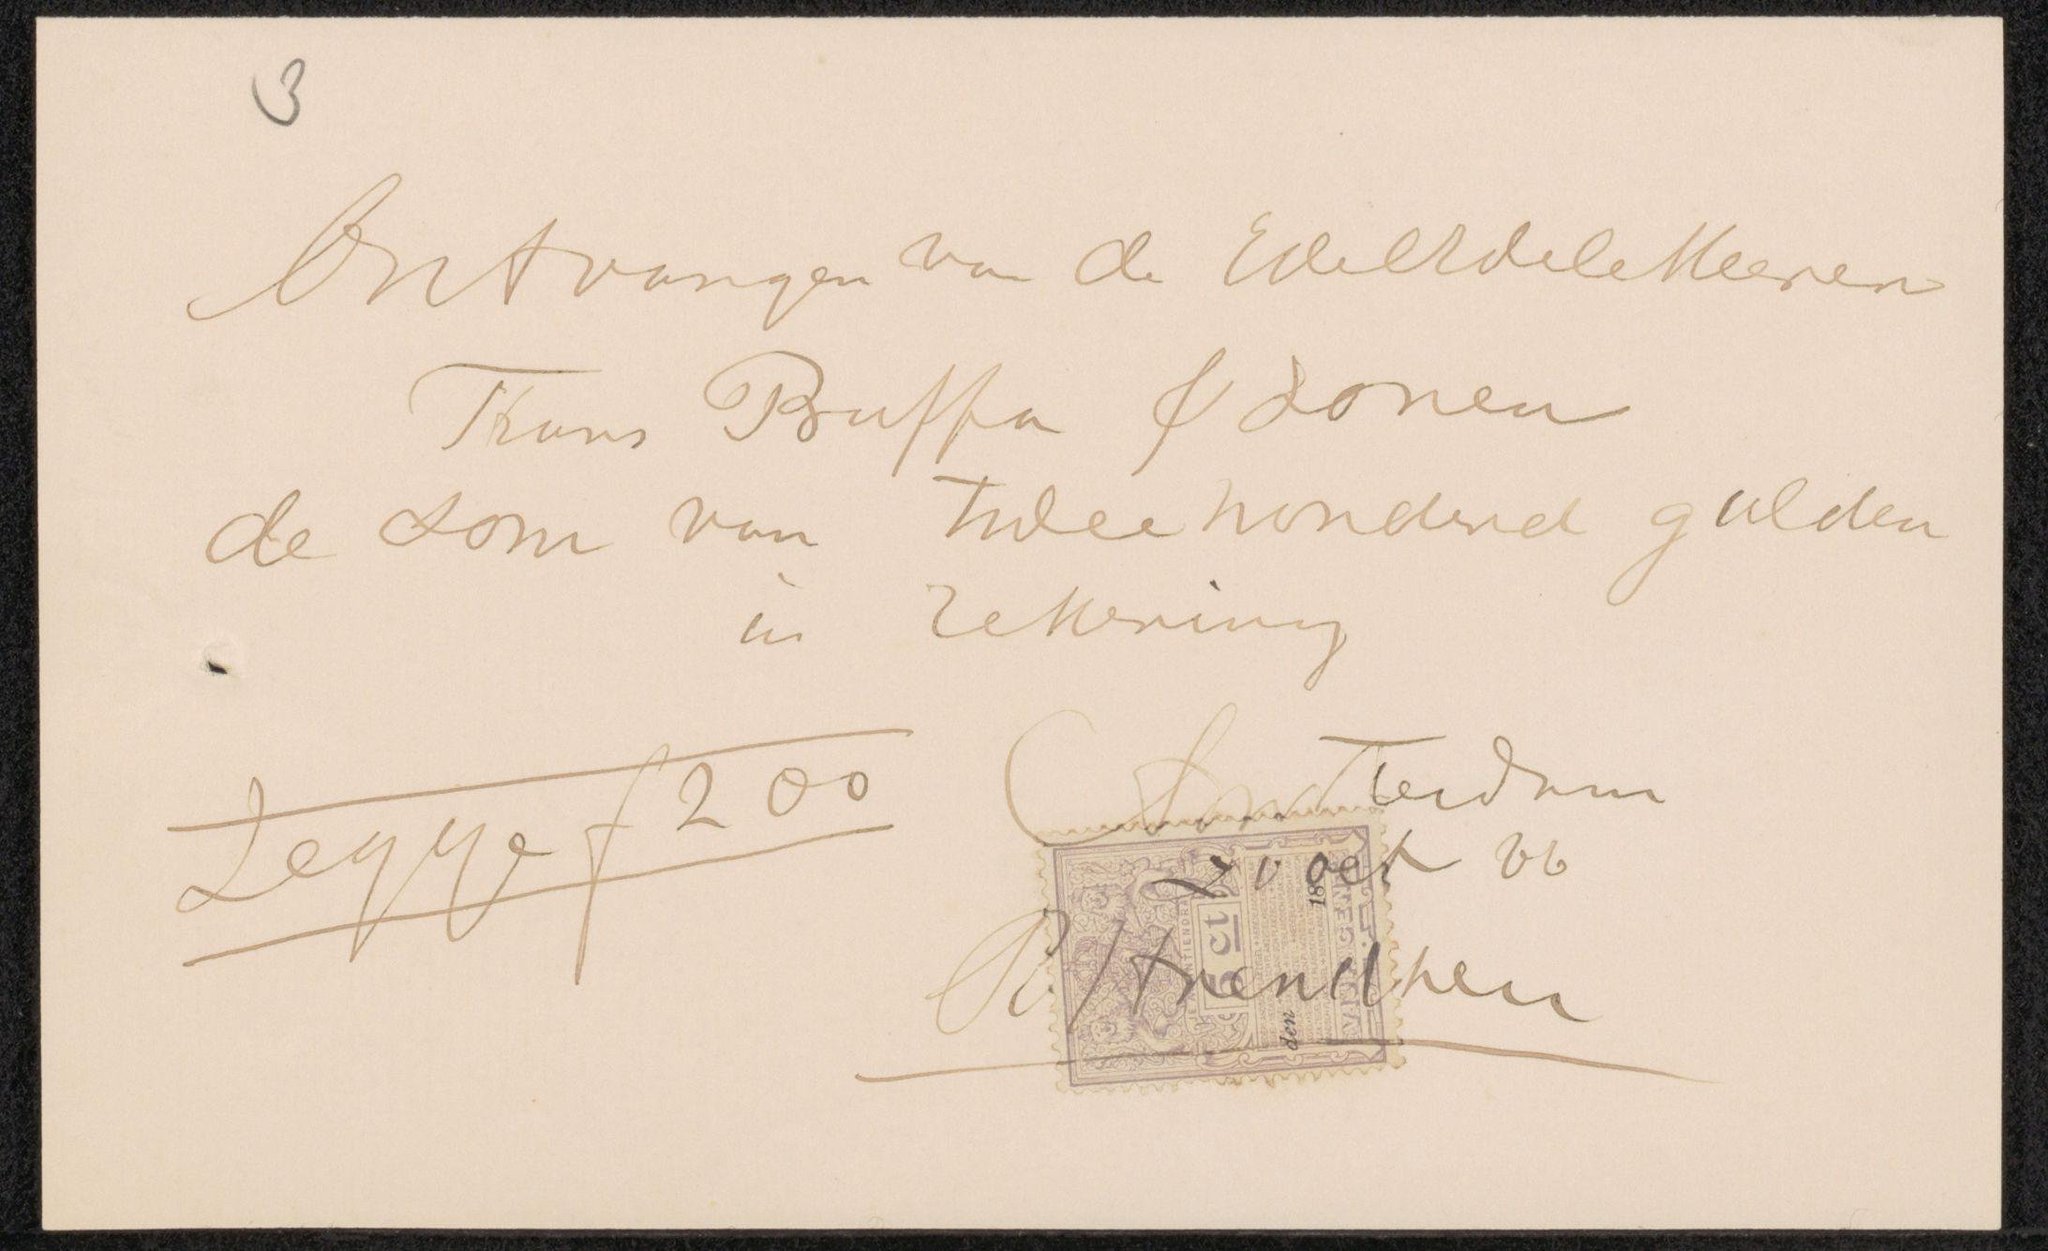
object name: ontvangstbewijs, kwitantie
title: Ontvangstbewijs aan Petrus Johannes Arendzen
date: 1886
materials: ink, paper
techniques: pen, writing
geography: amsterdam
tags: money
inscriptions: collector's mark: Lugt 2233